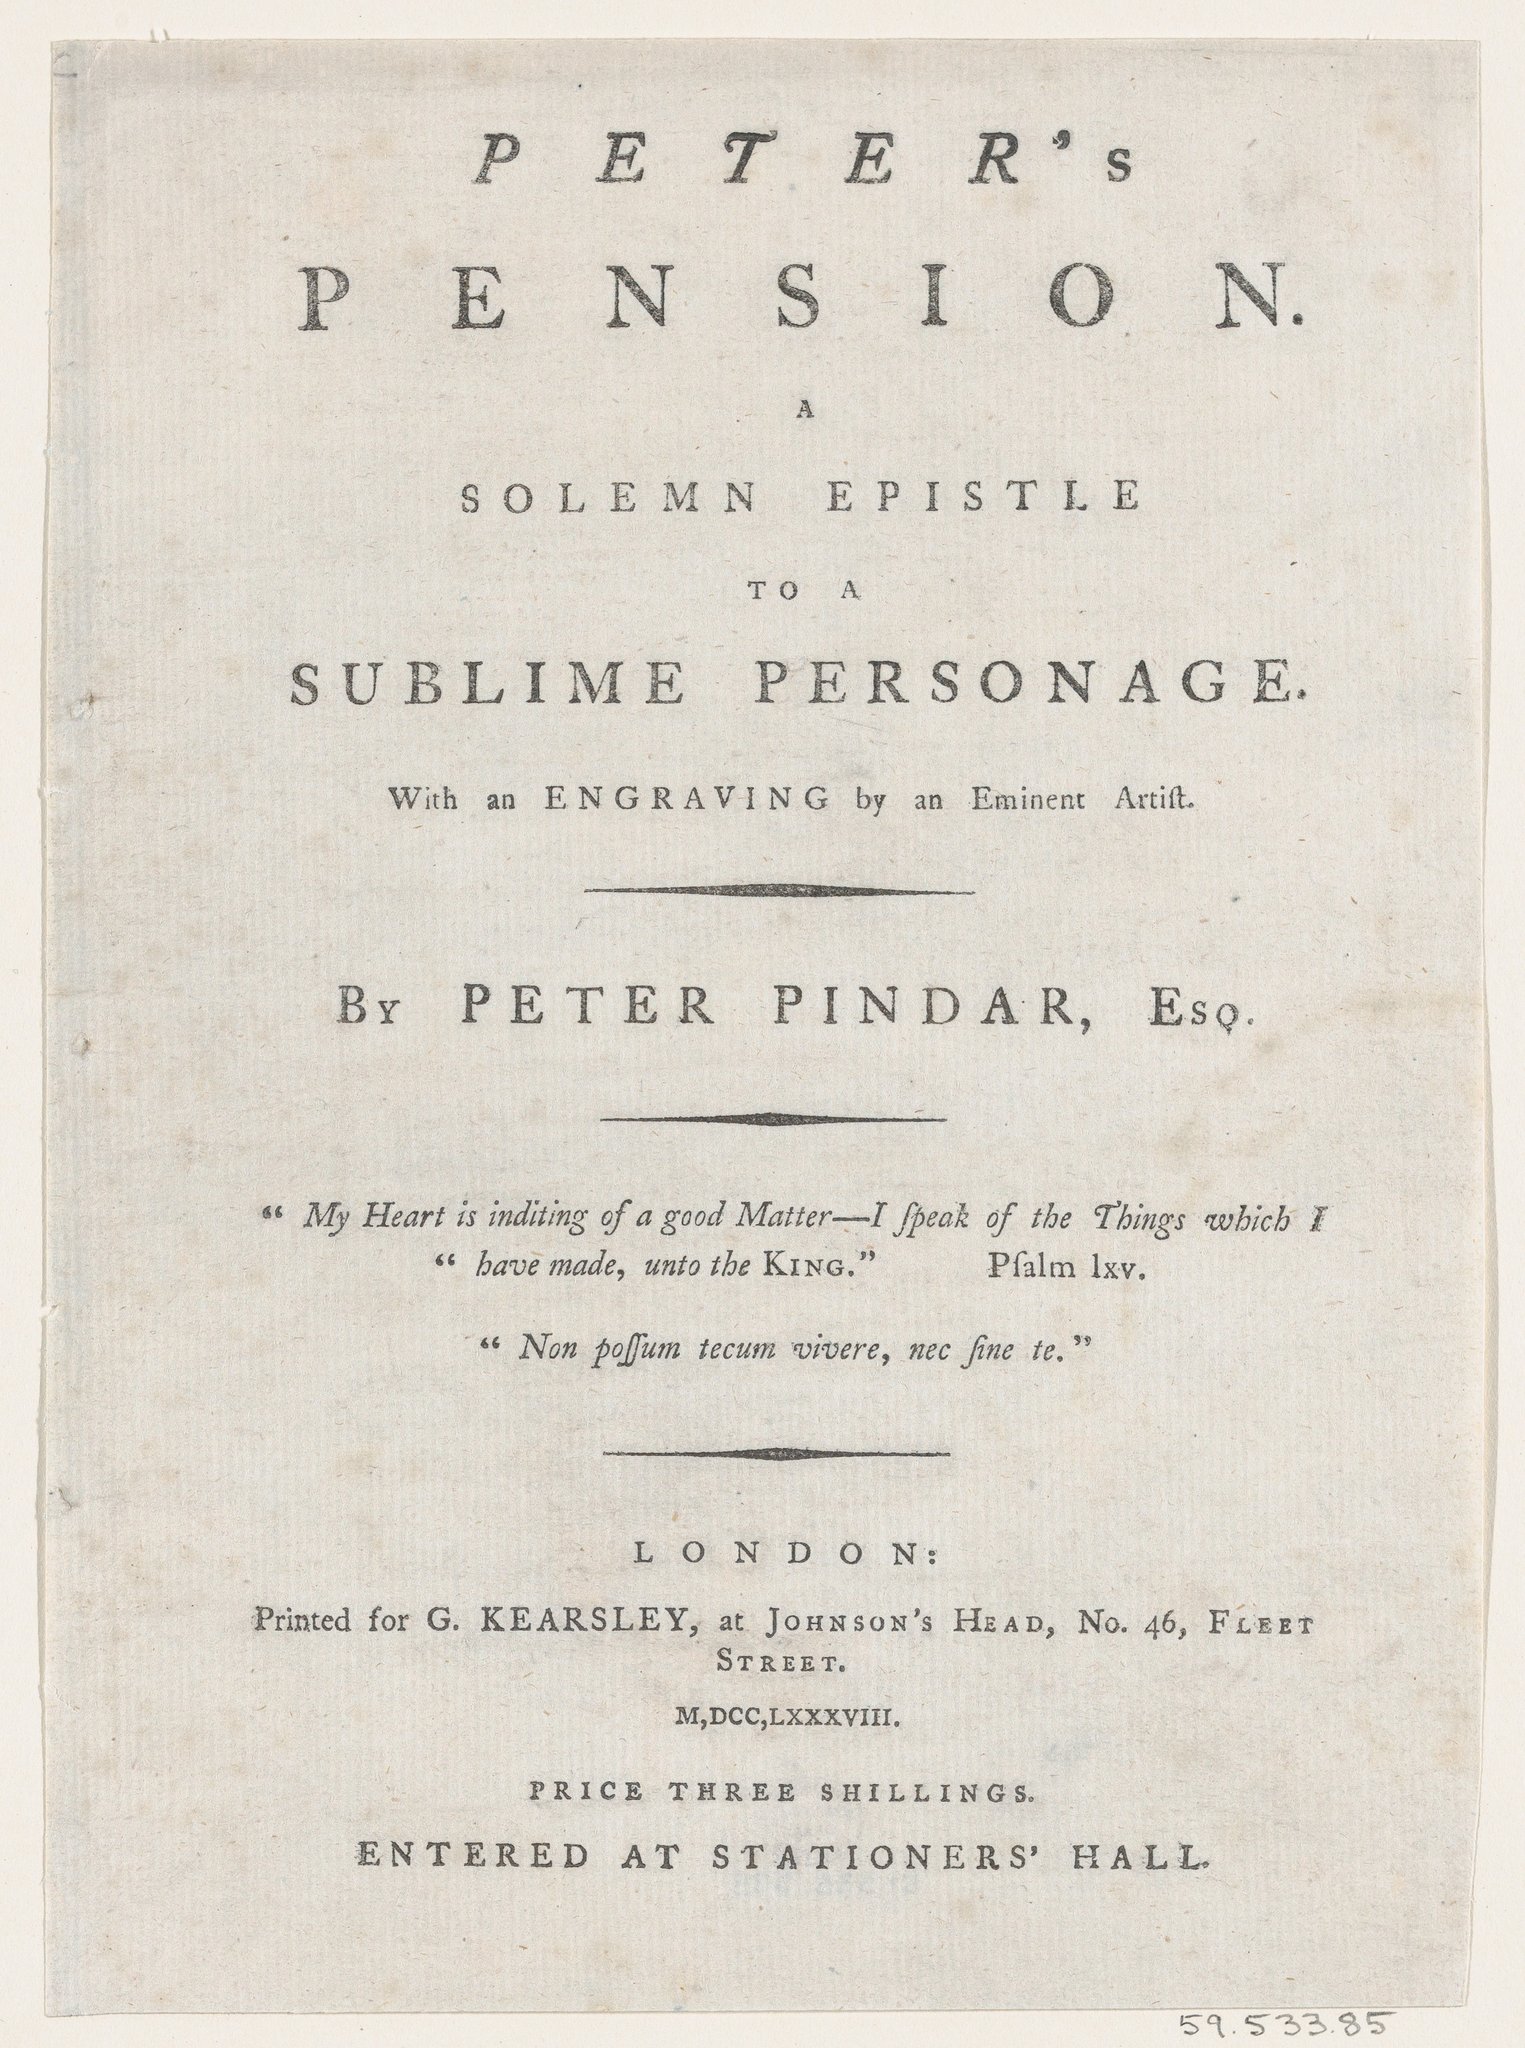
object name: print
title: Title page, from Peter's Pension by Peter Pindar, Esq.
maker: george kearsley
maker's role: publisher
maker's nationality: british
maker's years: 1753-1790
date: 1787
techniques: engraving